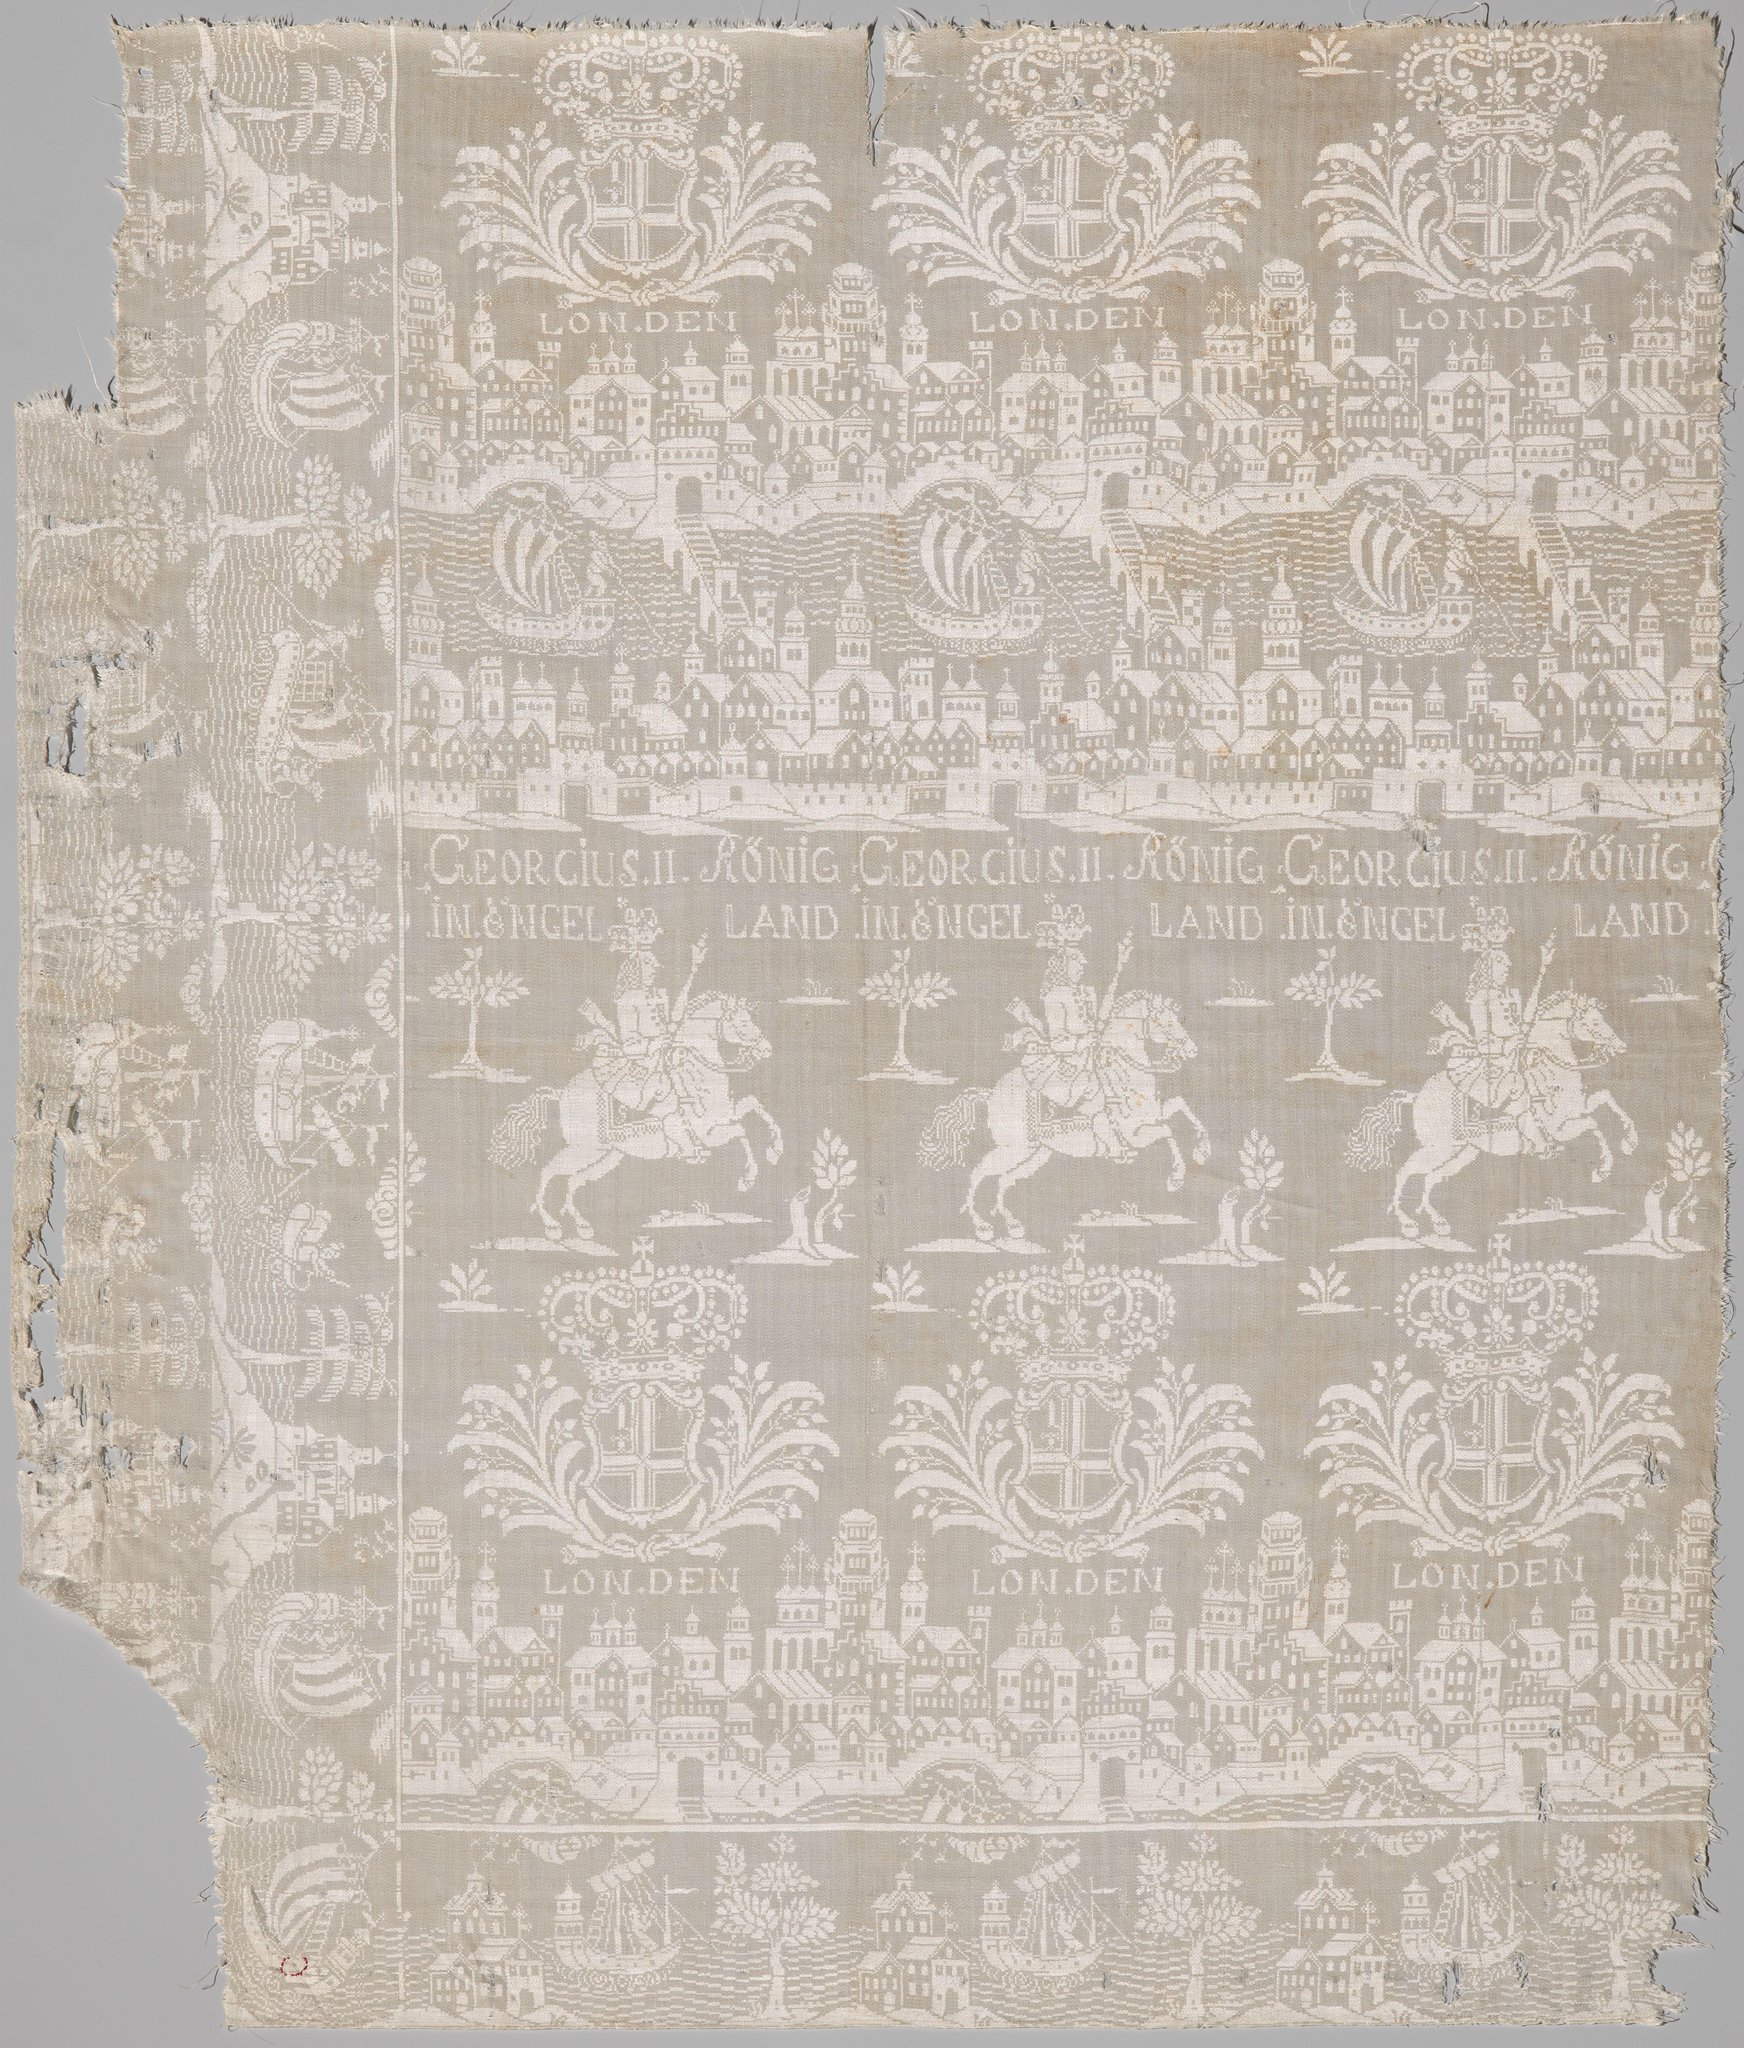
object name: fragment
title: Tafellaken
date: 1725-1750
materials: linen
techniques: damask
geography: germany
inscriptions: mark: ‘C’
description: Fragment van een wit linnen damasten tafellaken met een ruiterportret van George II van Engeland en een gezicht op Londen.